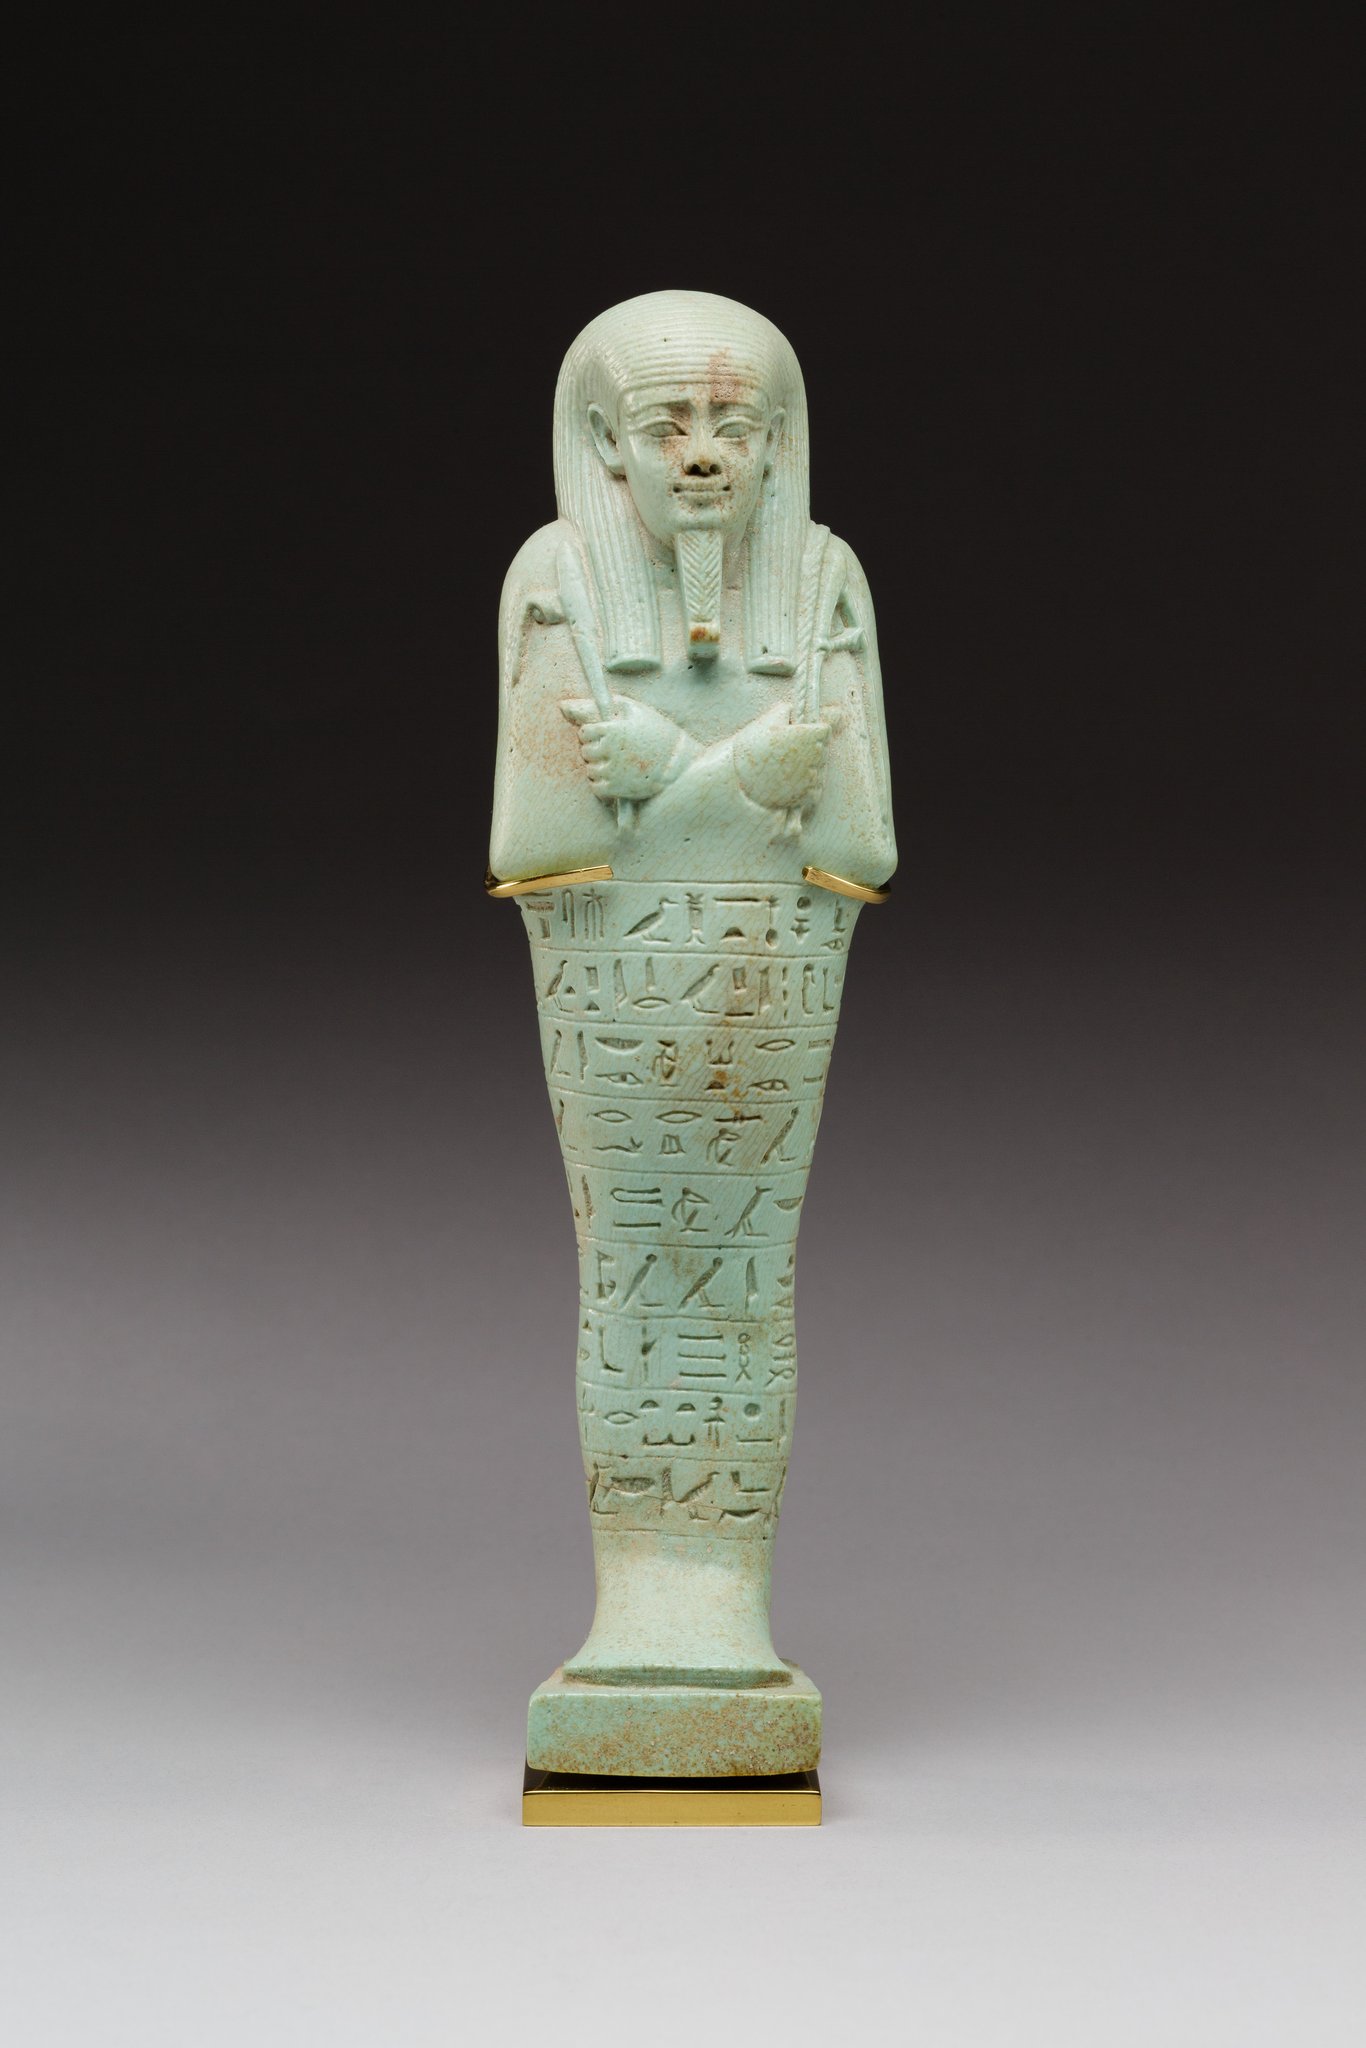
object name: shabti, neferibresaneith, shepenbastet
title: Shabti of Neferibresaneith, son of Shepenbastet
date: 570-526 BCE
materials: faience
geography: memphite region